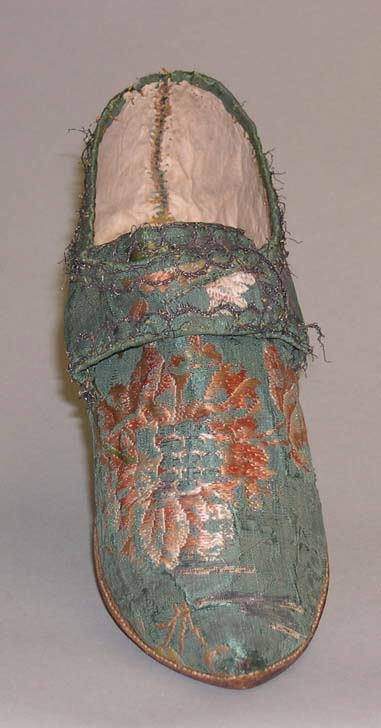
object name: shoe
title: Shoes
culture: french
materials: silk